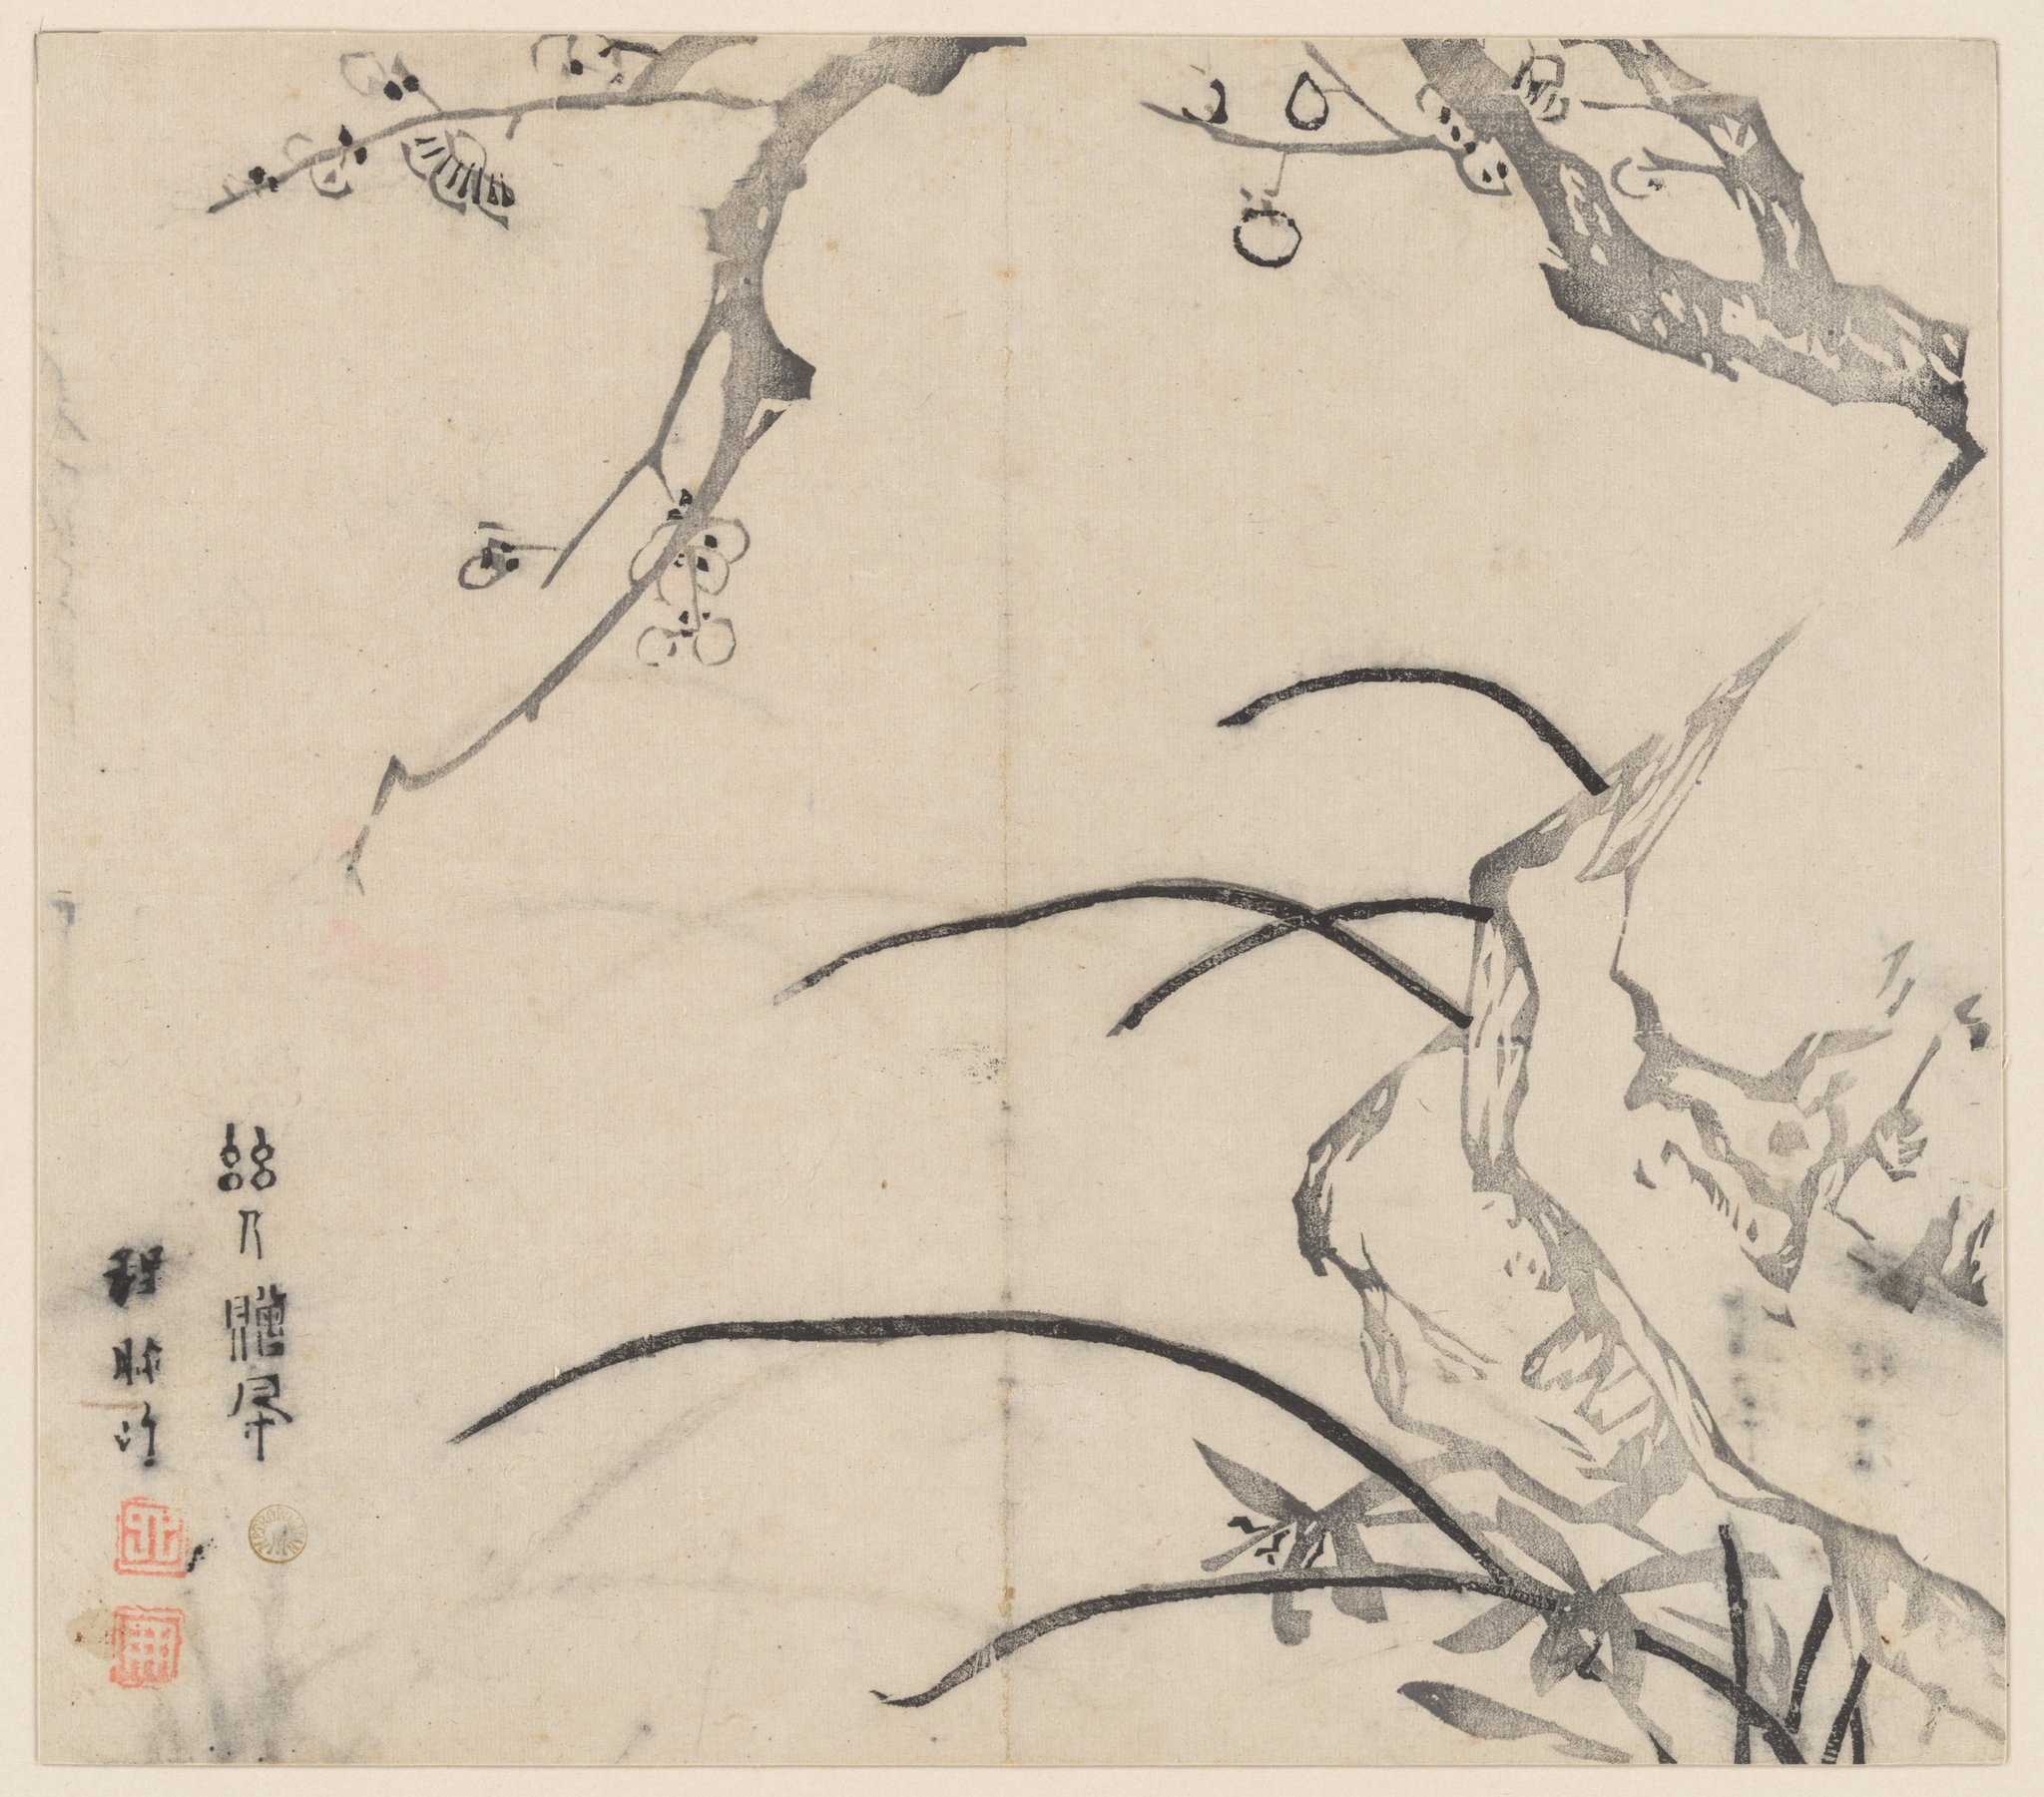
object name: print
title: Page from the Ten Bamboo Studio Manual of Painting and Calligraphy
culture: chinese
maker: hu zhengyan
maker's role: artist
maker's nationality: chinese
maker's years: 1584-1634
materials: ink, paper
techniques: printing